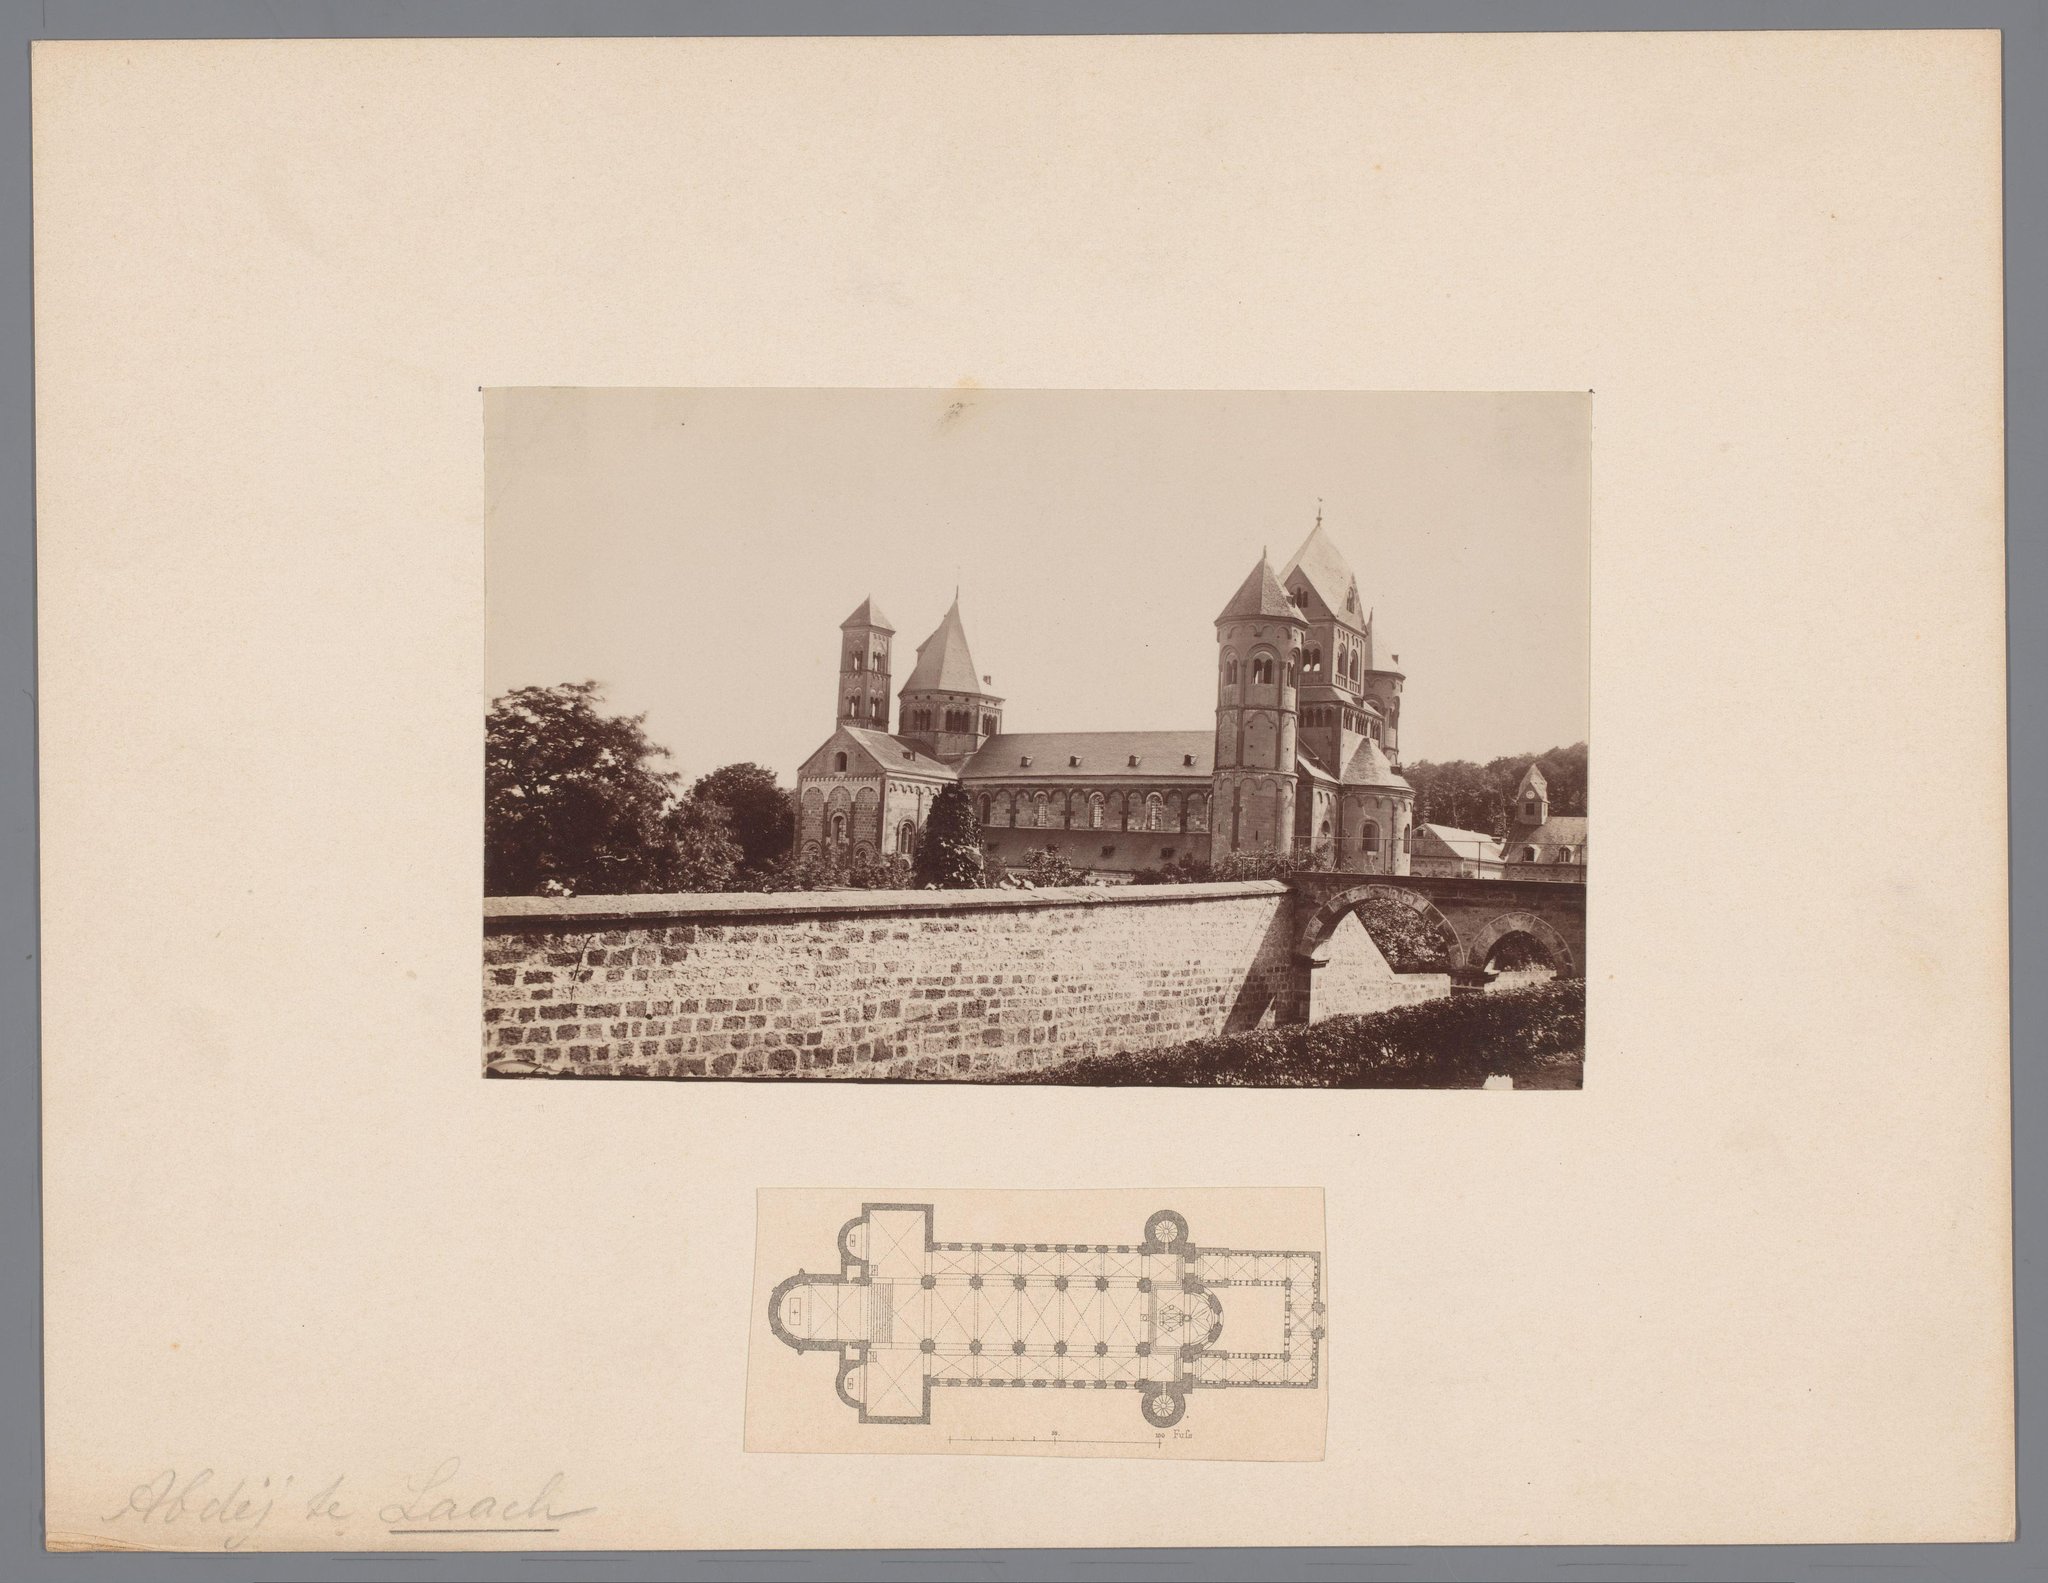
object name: area plan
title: Plattegrond van de abdij van Maria Laach bij Andernach, Duitsland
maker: Anonymous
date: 1860-1890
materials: cardboard, paper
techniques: printing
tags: abbey, monastery, convent ~ roman catholic church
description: Plattegrond zit samen met foto (RP-F-2003-79-1) op één blad.